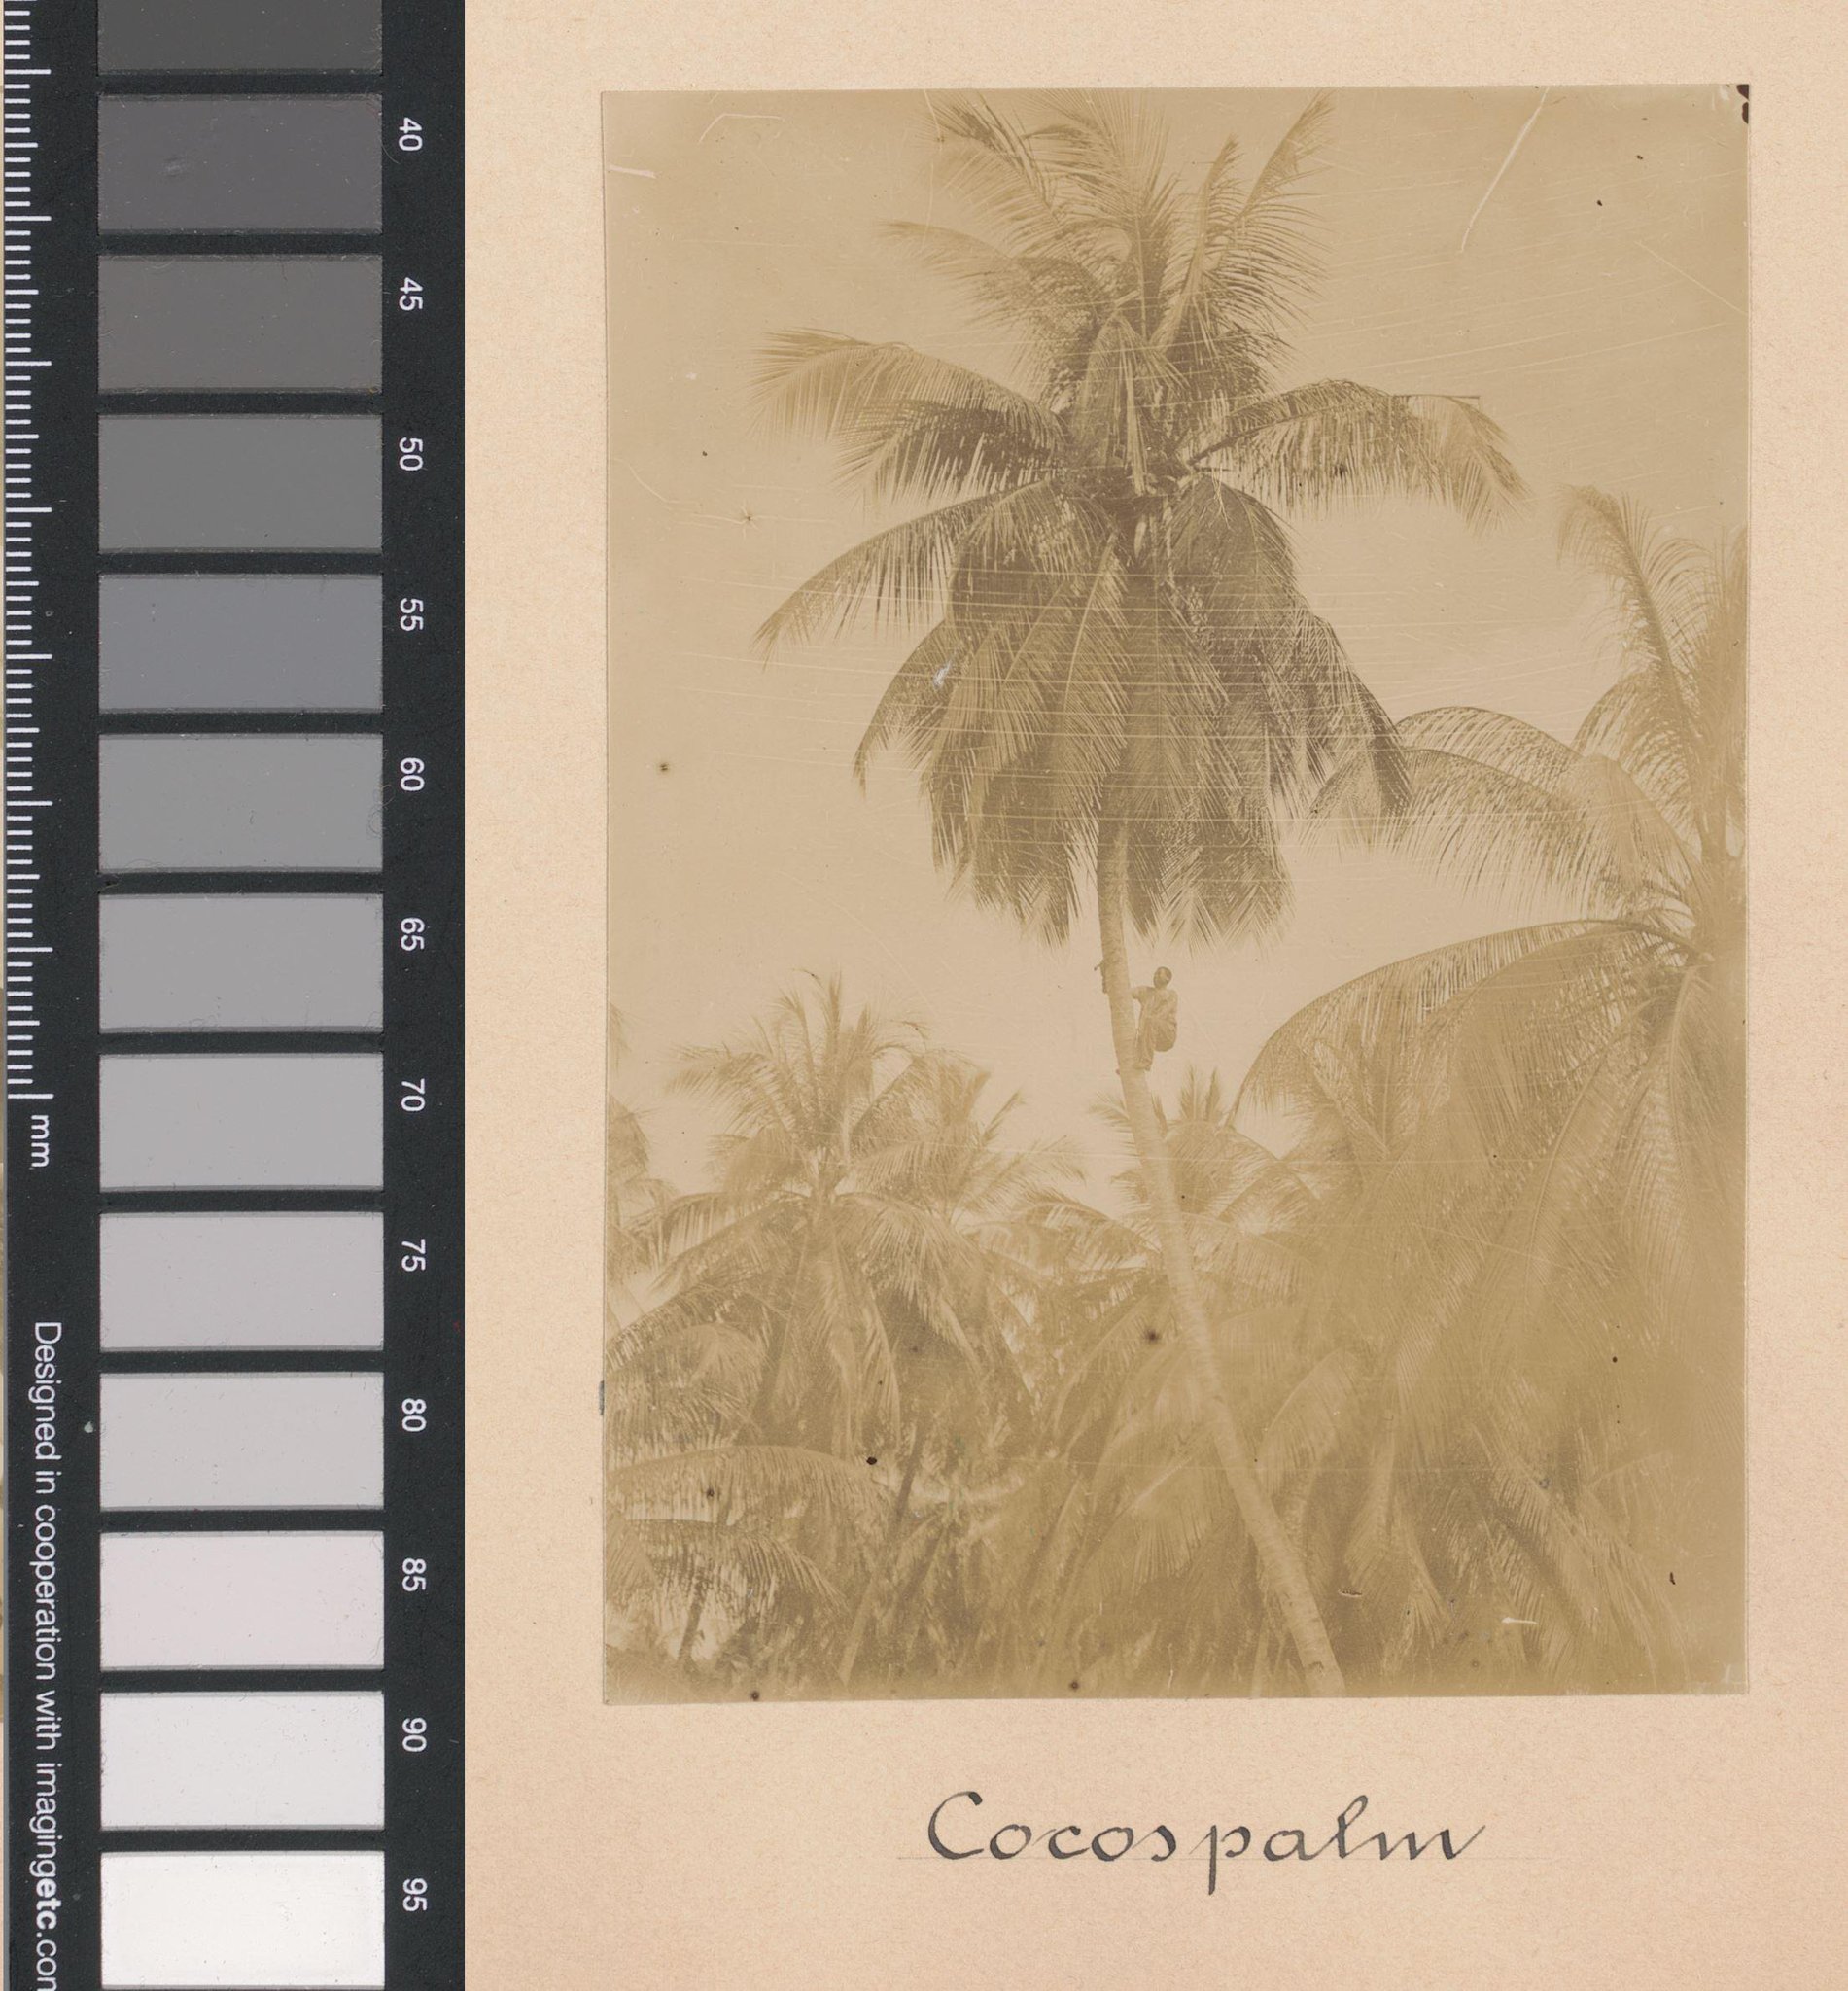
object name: photograph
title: Cocospalm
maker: eugen klein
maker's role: fotograaf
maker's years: 1869-1927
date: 1900-1905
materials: cardboard, photographic support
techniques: gelatin silver print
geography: suriname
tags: suriname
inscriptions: inscription: ‘Suriname / Cocospalm’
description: Een kokospalm. Een jongen is tot halverwege de stam geklommen. Fotoafdruk op een blad geplakt samen met twee andere foto's. Onderdeel van een groep van 44 foto's van Paramaribo, Suriname en Curaçao, ca. 1900-1905, opgeplakt op kartons en voorzien van opschriften.